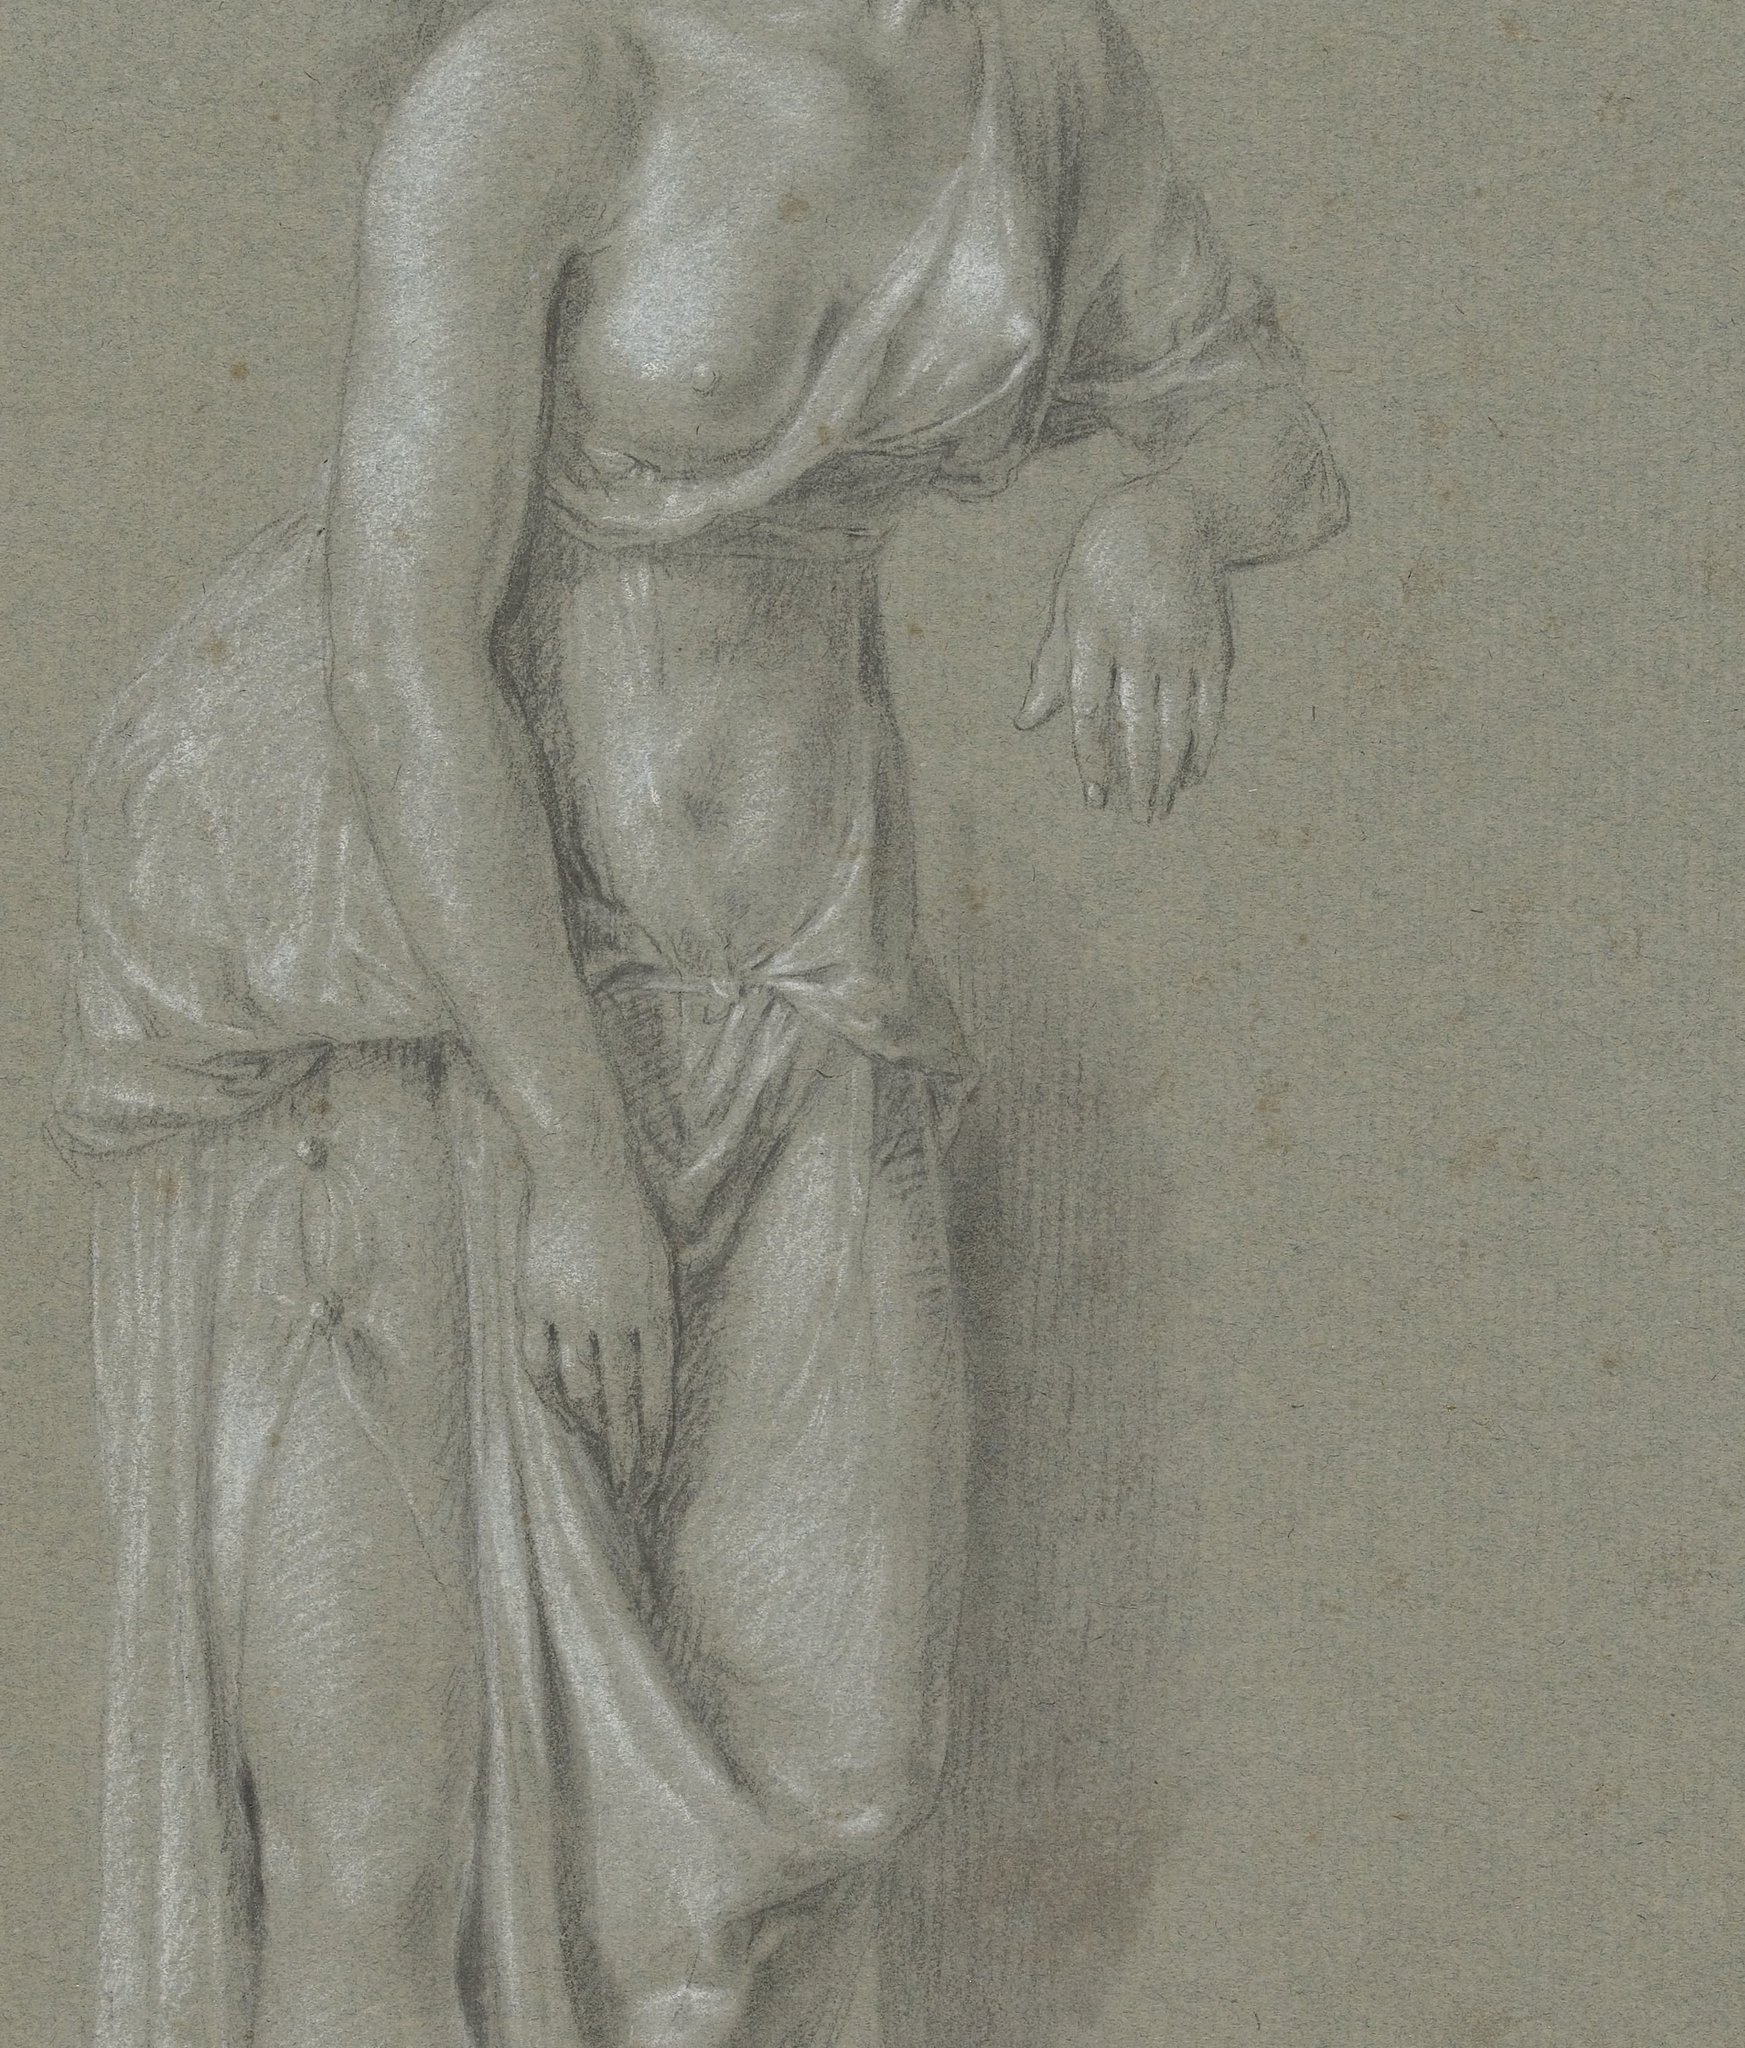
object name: drawing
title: Figuurstudie van een vrouw in een klassiek gewaad, driekwart naar rechts staand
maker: hendrik hoogers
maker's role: draughtsman, mayor, print maker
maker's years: 1747-1814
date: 1796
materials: chalk, paper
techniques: stumping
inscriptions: date: ‘96’